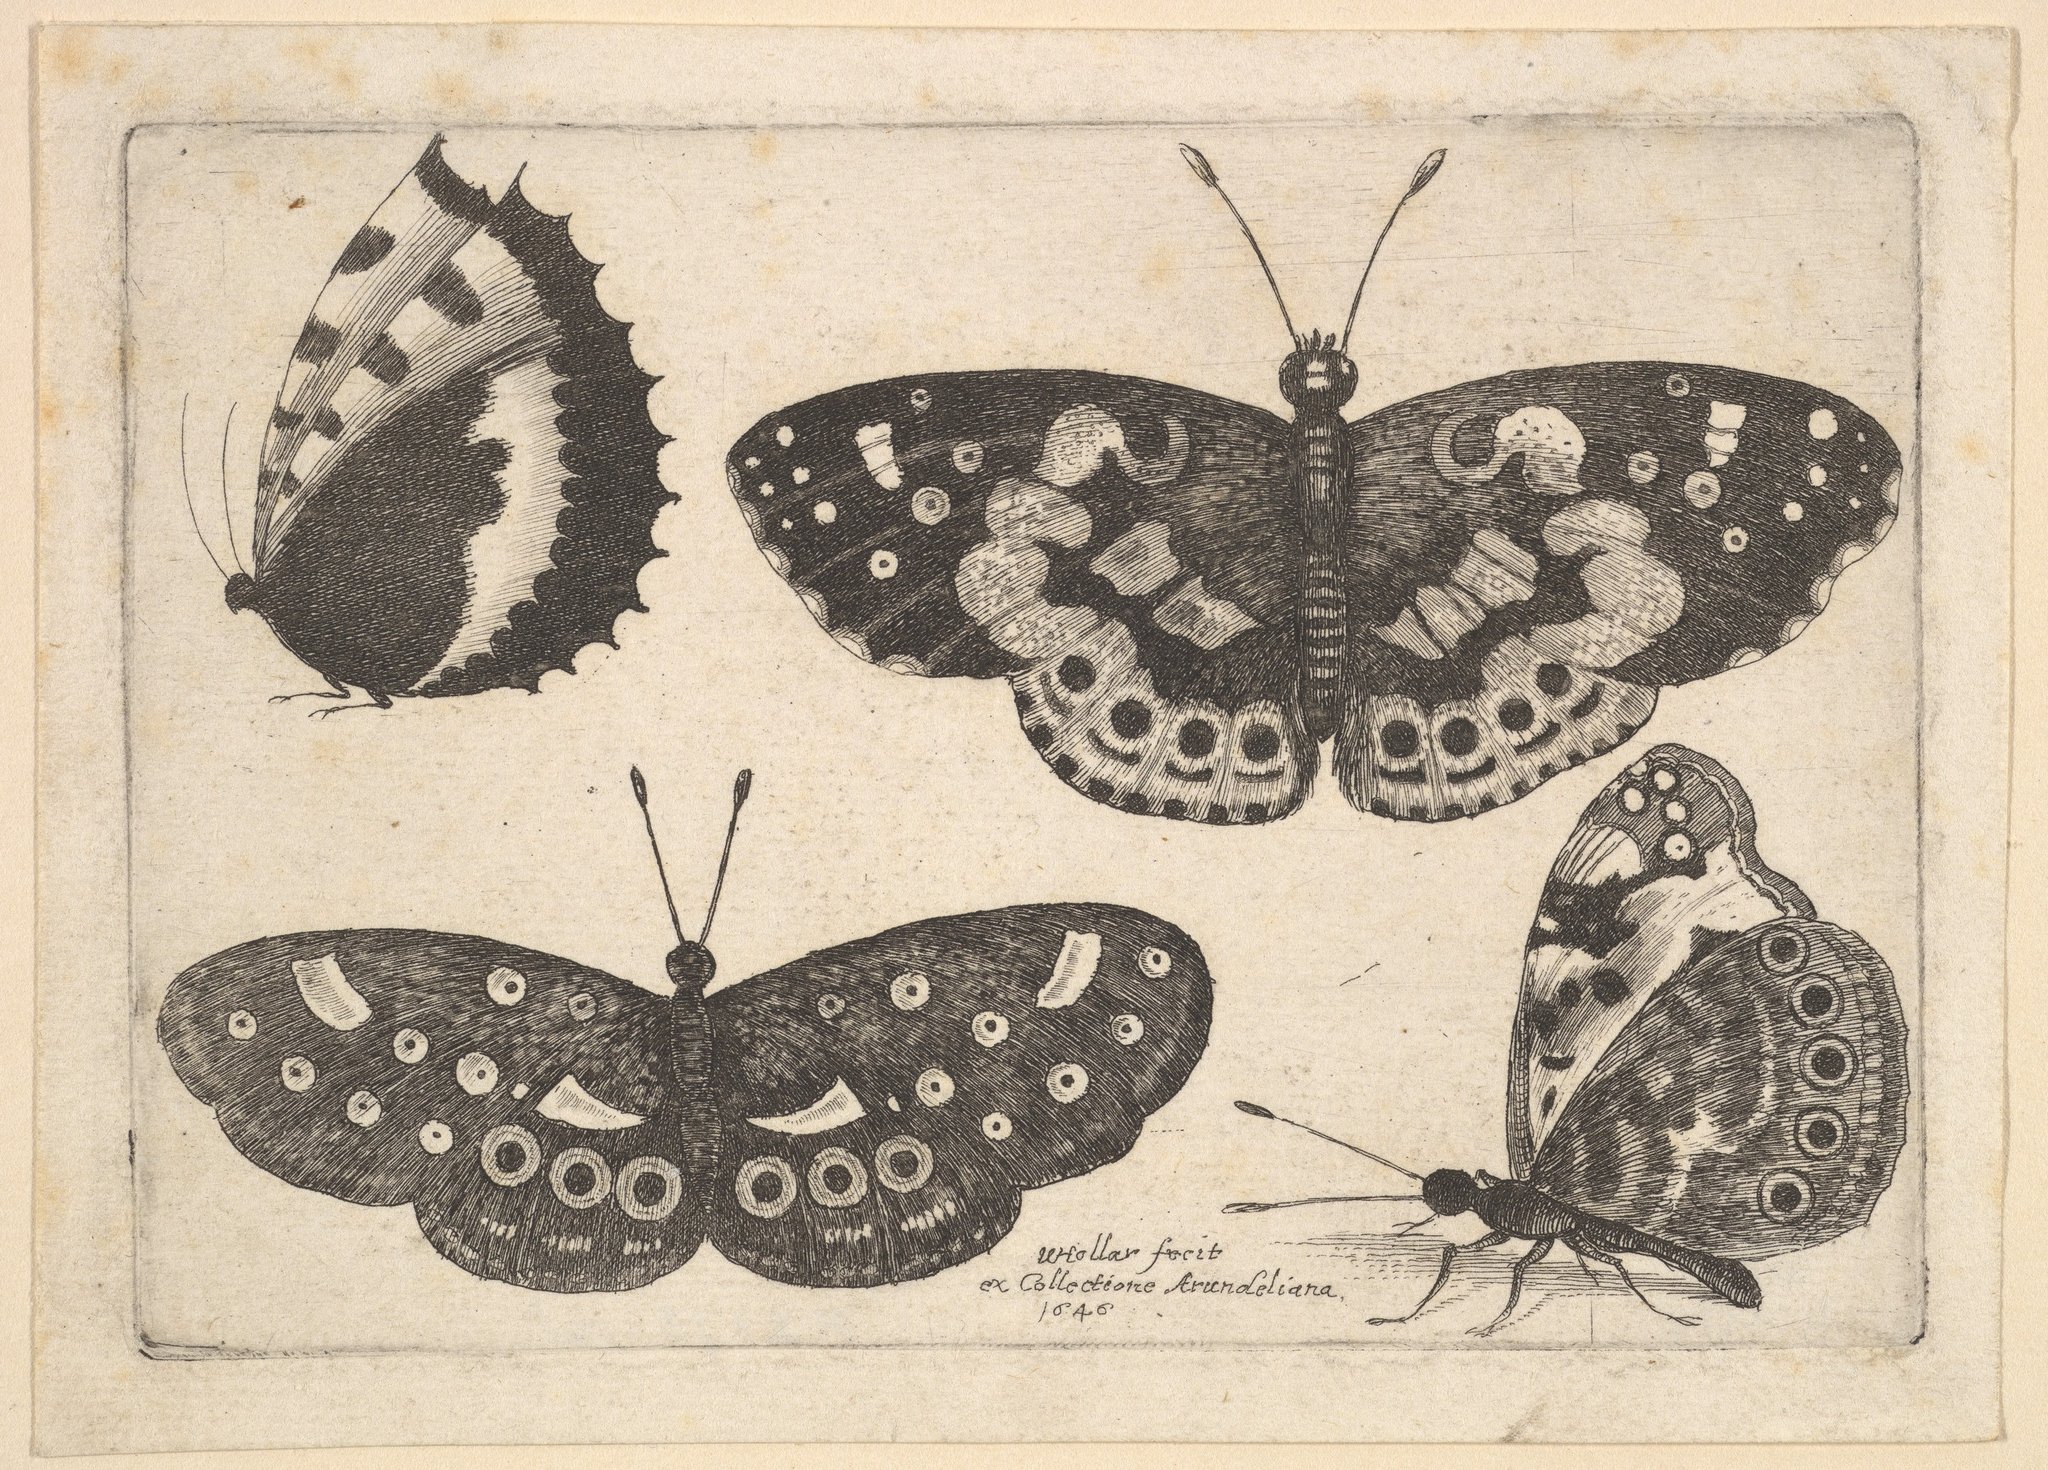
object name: print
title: Four Butterflies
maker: wenceslaus hollar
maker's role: artist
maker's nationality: bohemian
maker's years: 1607-1677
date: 1646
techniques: etching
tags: butterflies